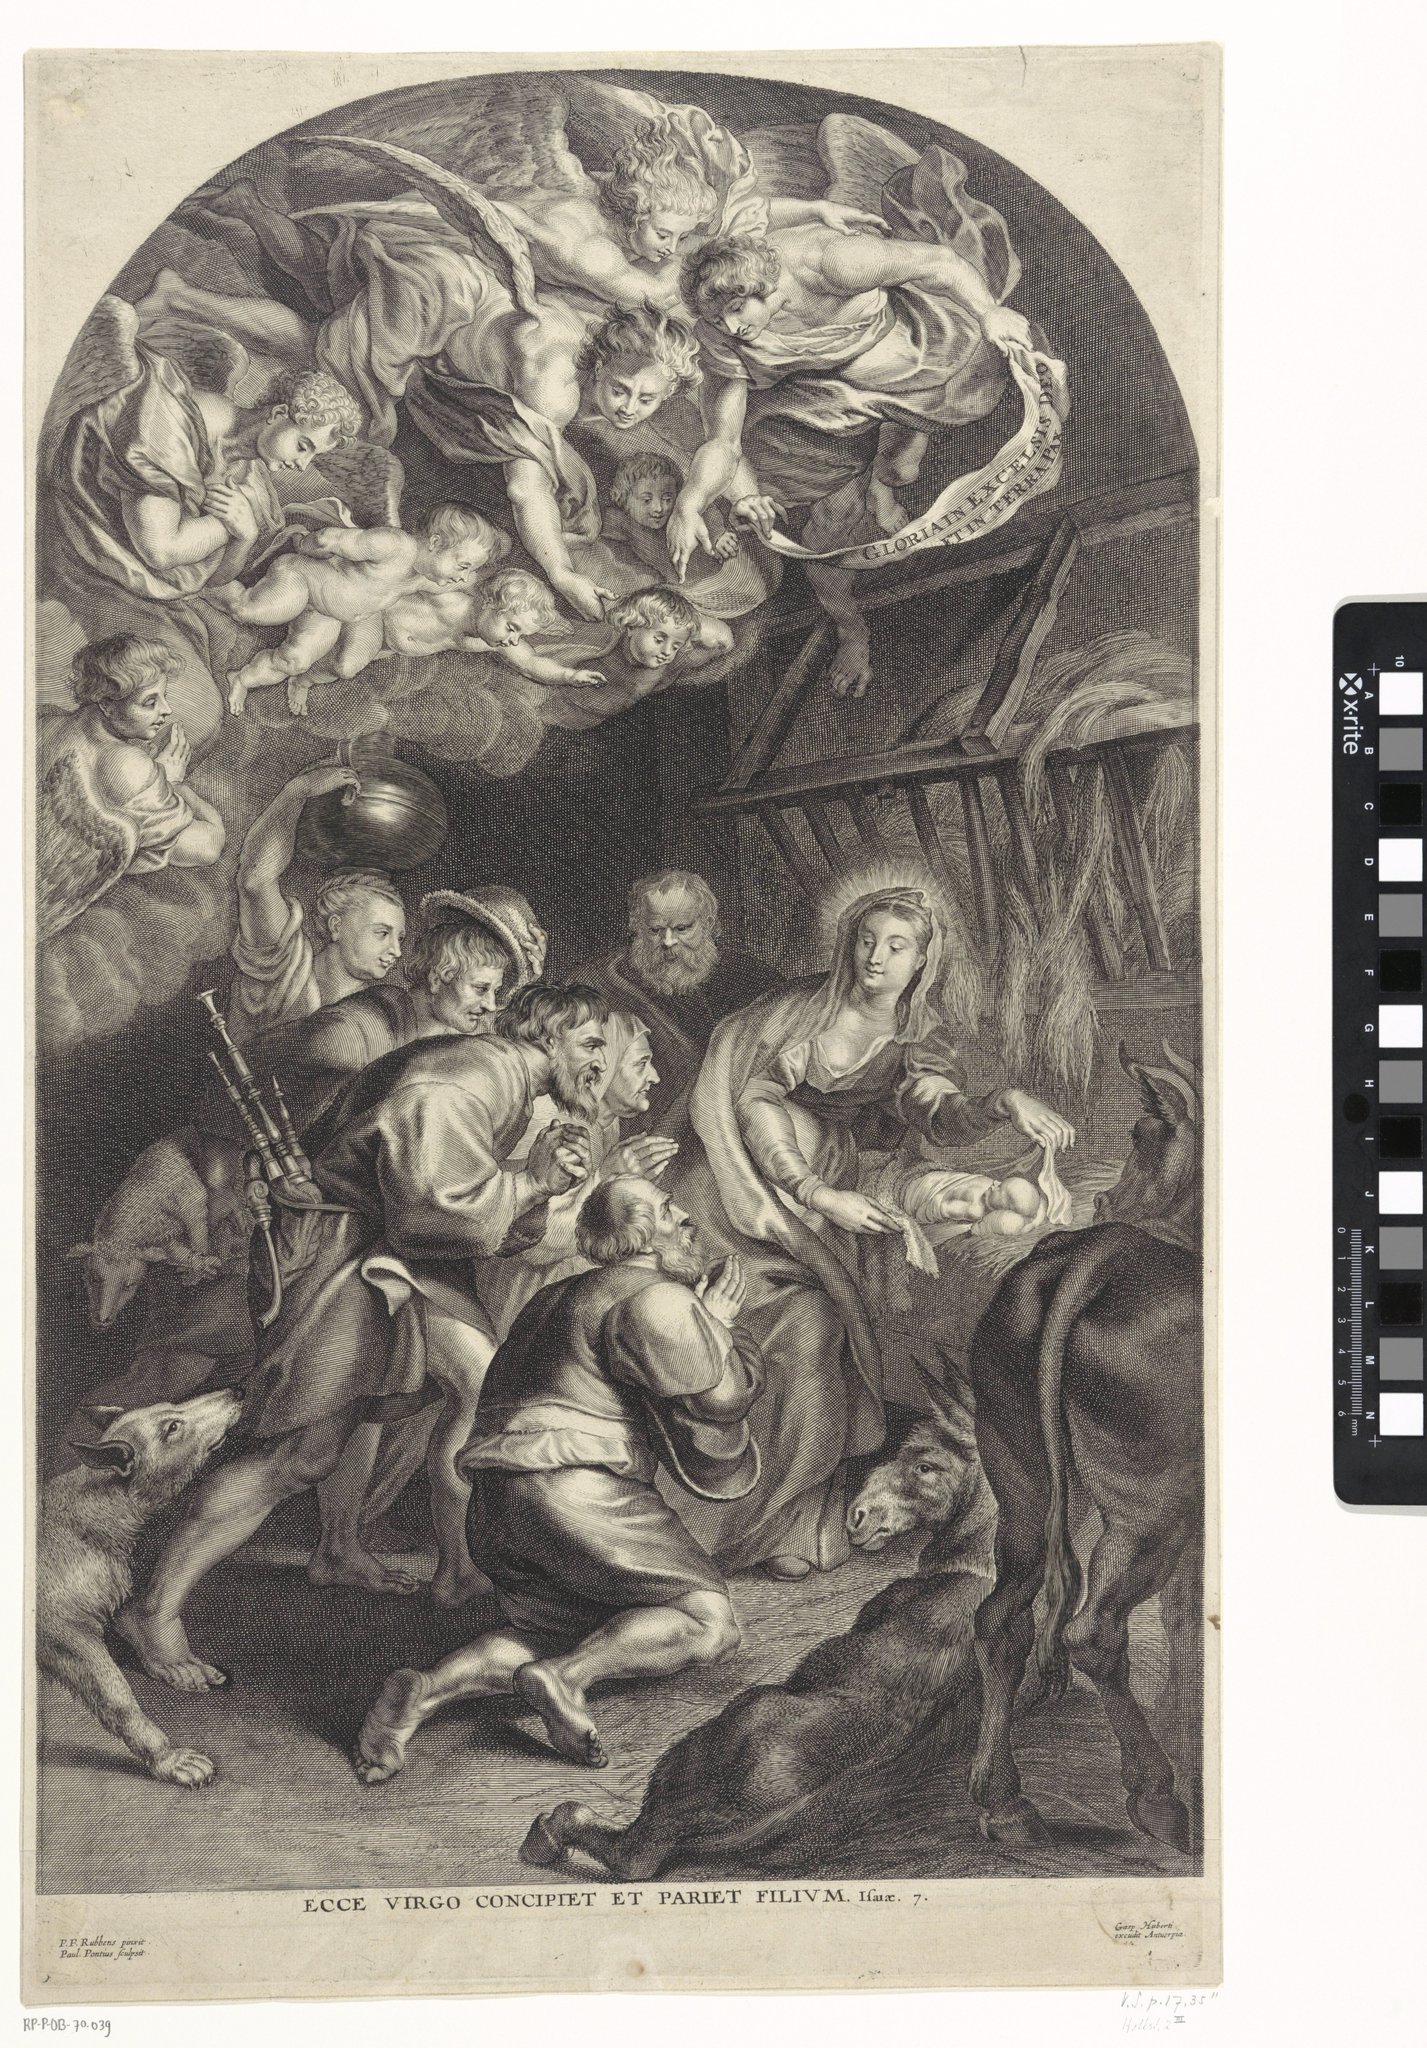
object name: print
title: Aanbidding door de herders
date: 1616-1657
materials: paper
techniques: engraving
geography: antwerp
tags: adoration of the christ-child by the shepherds; mary and joseph present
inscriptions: collector's mark: Lugt 240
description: Het Christuskind ligt op het hooi in de stal. Maria tilt het laken op om hem aan de herders te tonen. Achter haar staat Jozef. De herders en hun vrouwen richten zich in aanbidding tot het Christuskind. Engelen kijken toe vanuit de hemel. Eén van hen houdt een banderol vast waarop een opschrift in het Latijn. In de marge een Bijbelcitaat uit Jes. 7 in het Latijn.